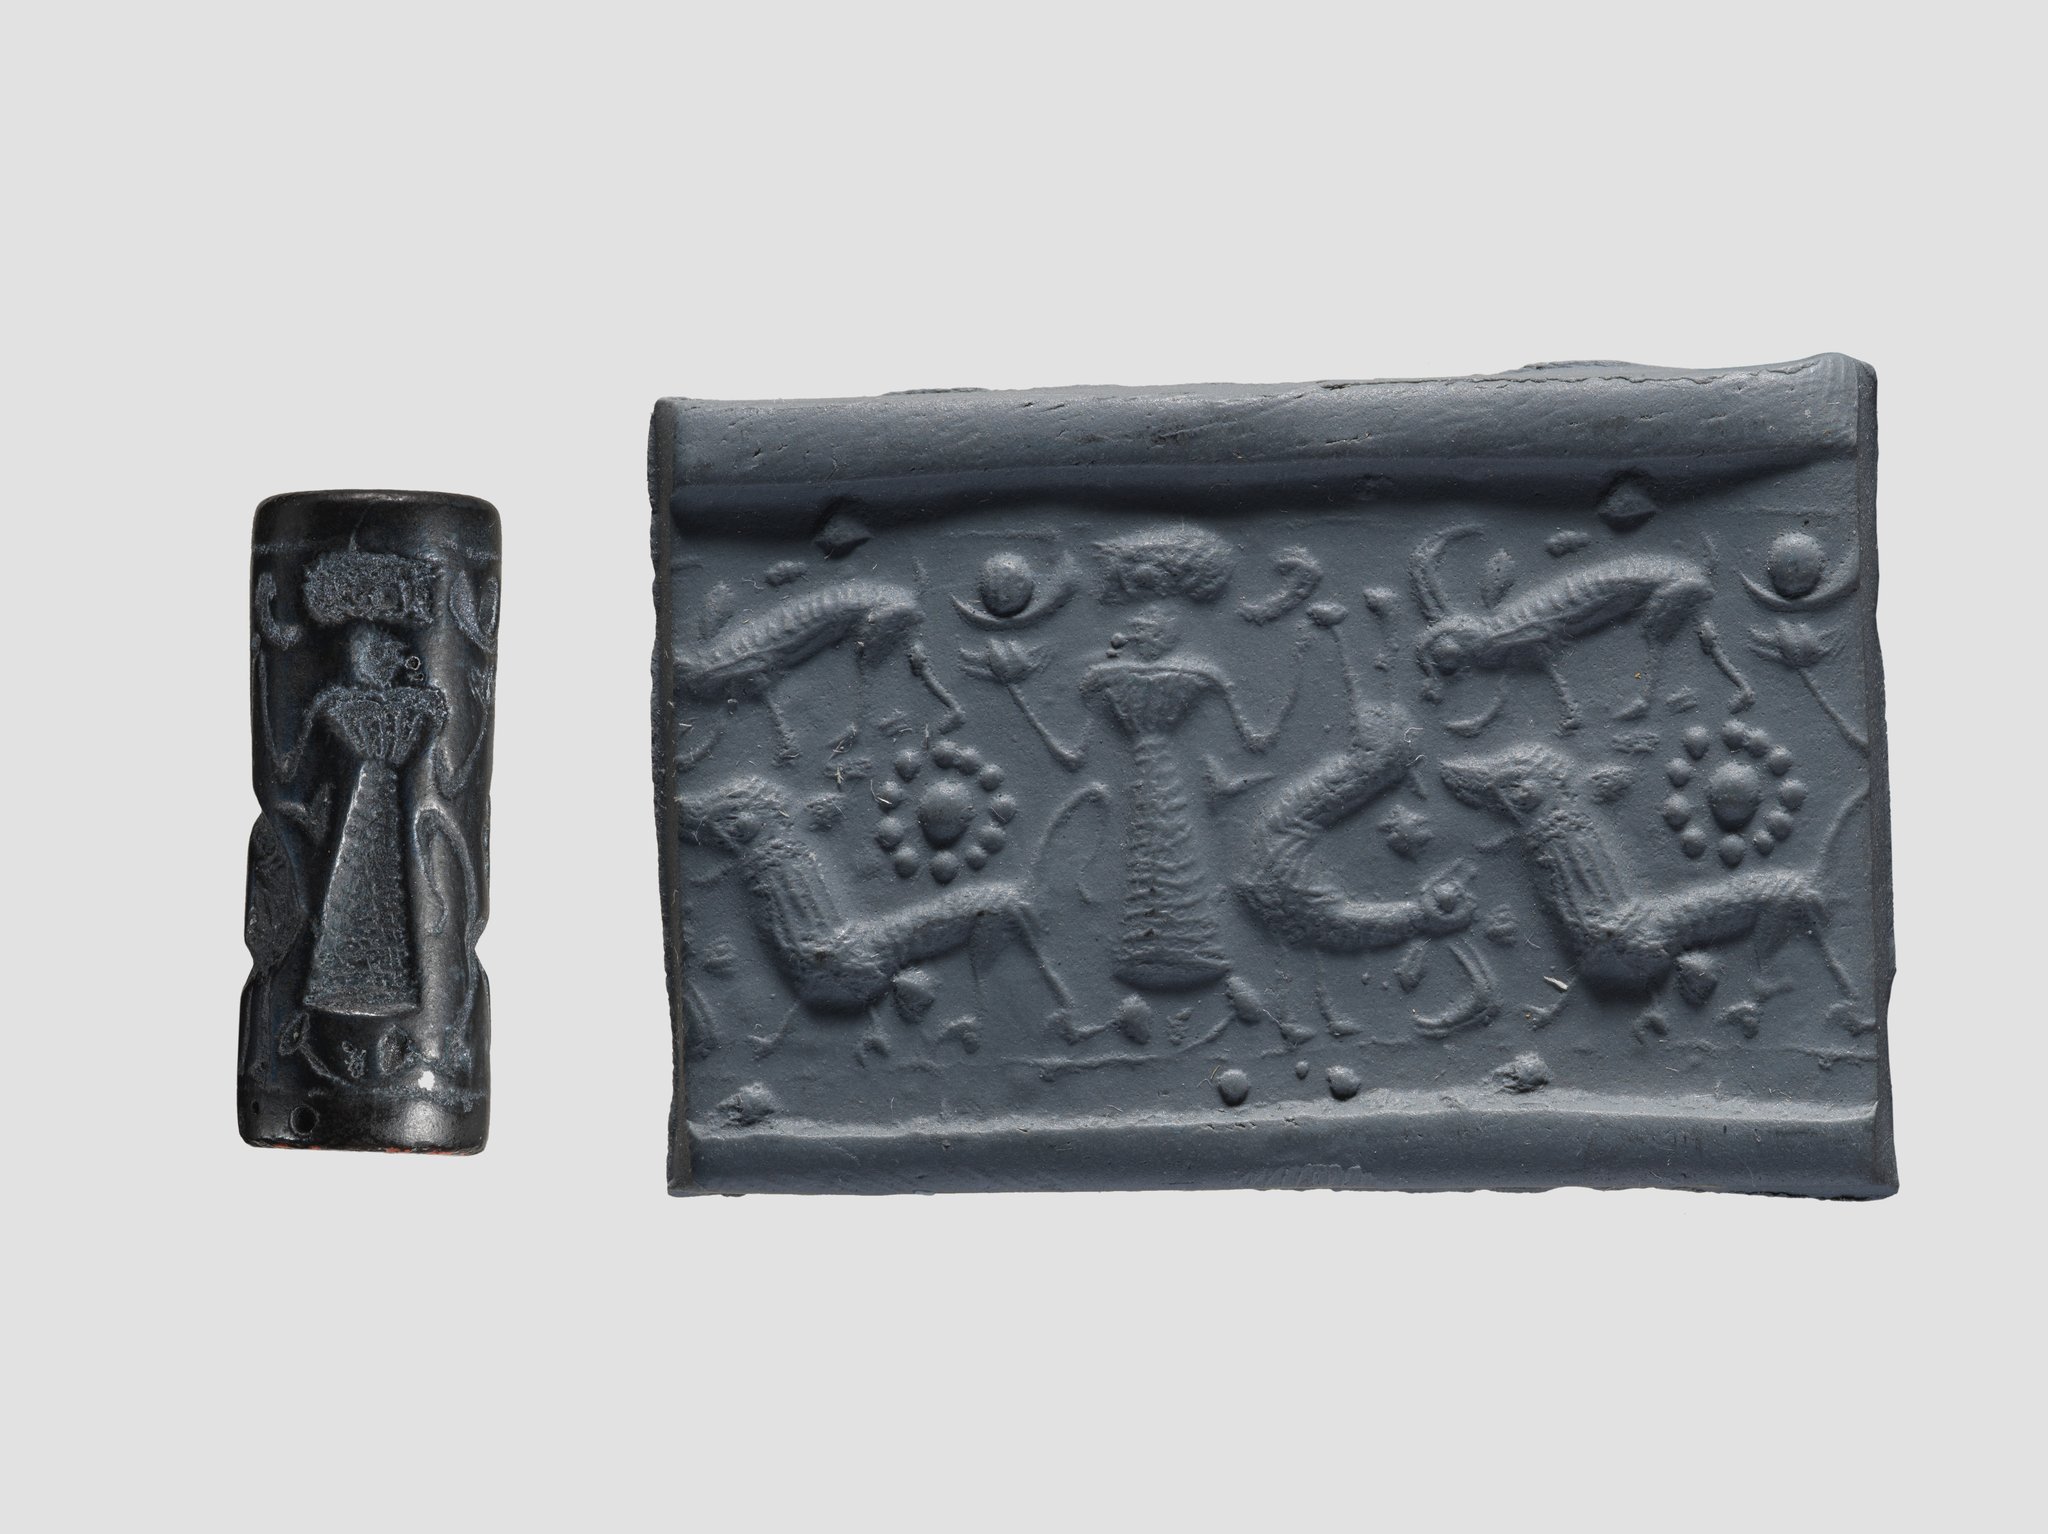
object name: cylinder seal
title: Cylinder seal and modern impression: female figure, ibex, lion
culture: cypriot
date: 1400-1201 BCE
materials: mineral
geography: cyprus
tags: women,lions,ibex